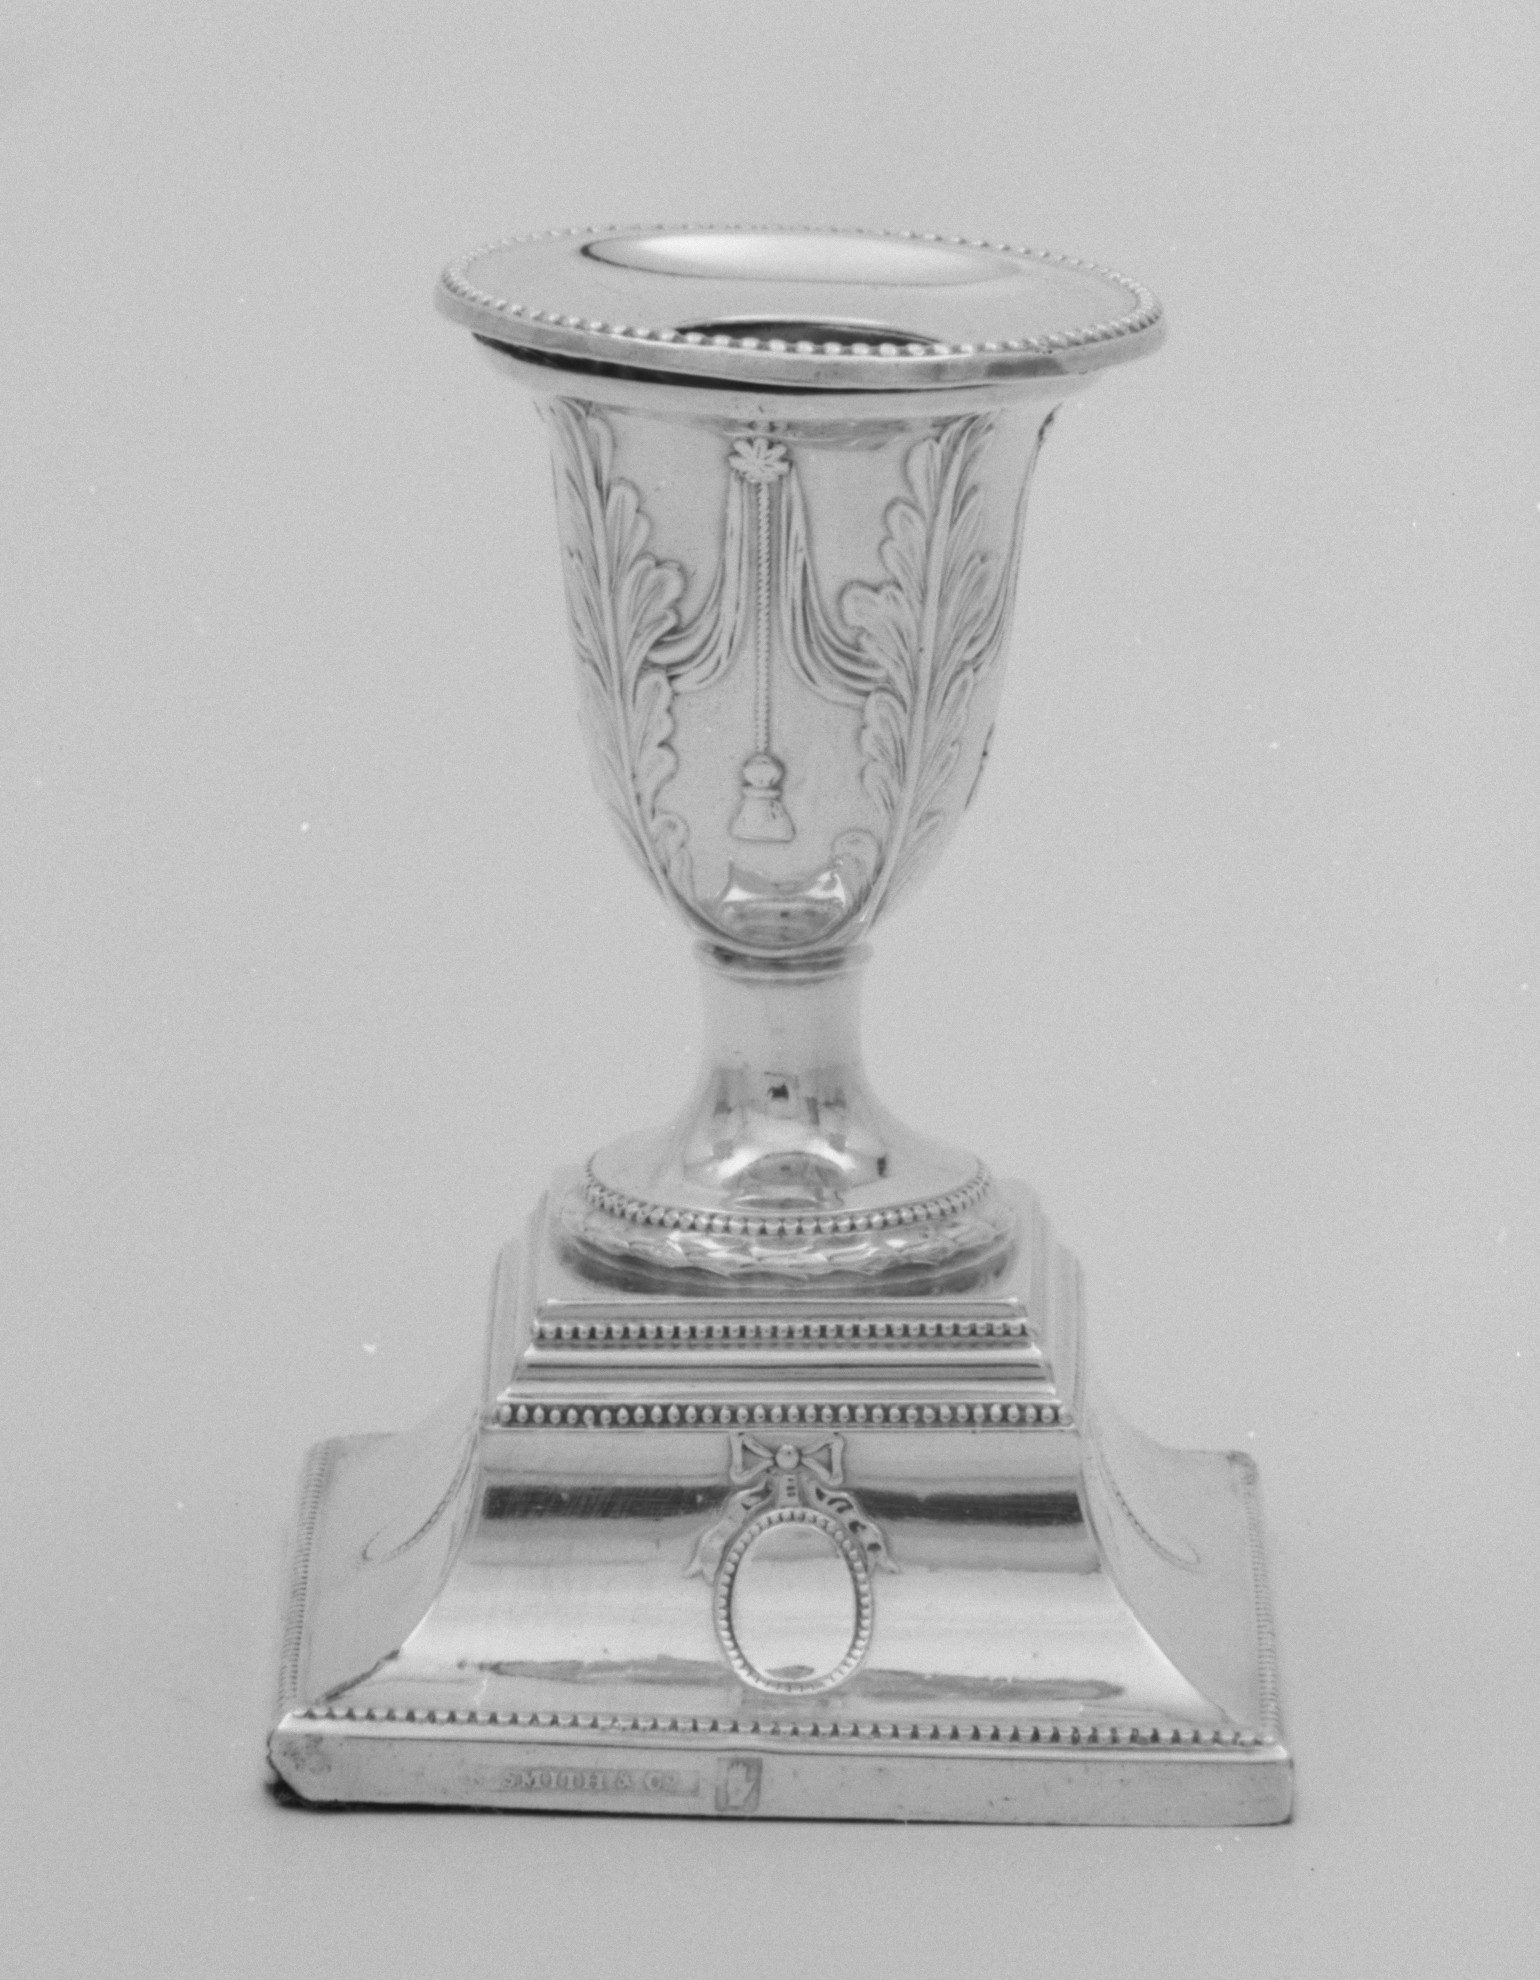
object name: candlestick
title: Pair of piano candlesticks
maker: n. smith and co.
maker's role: maker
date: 1784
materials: metal